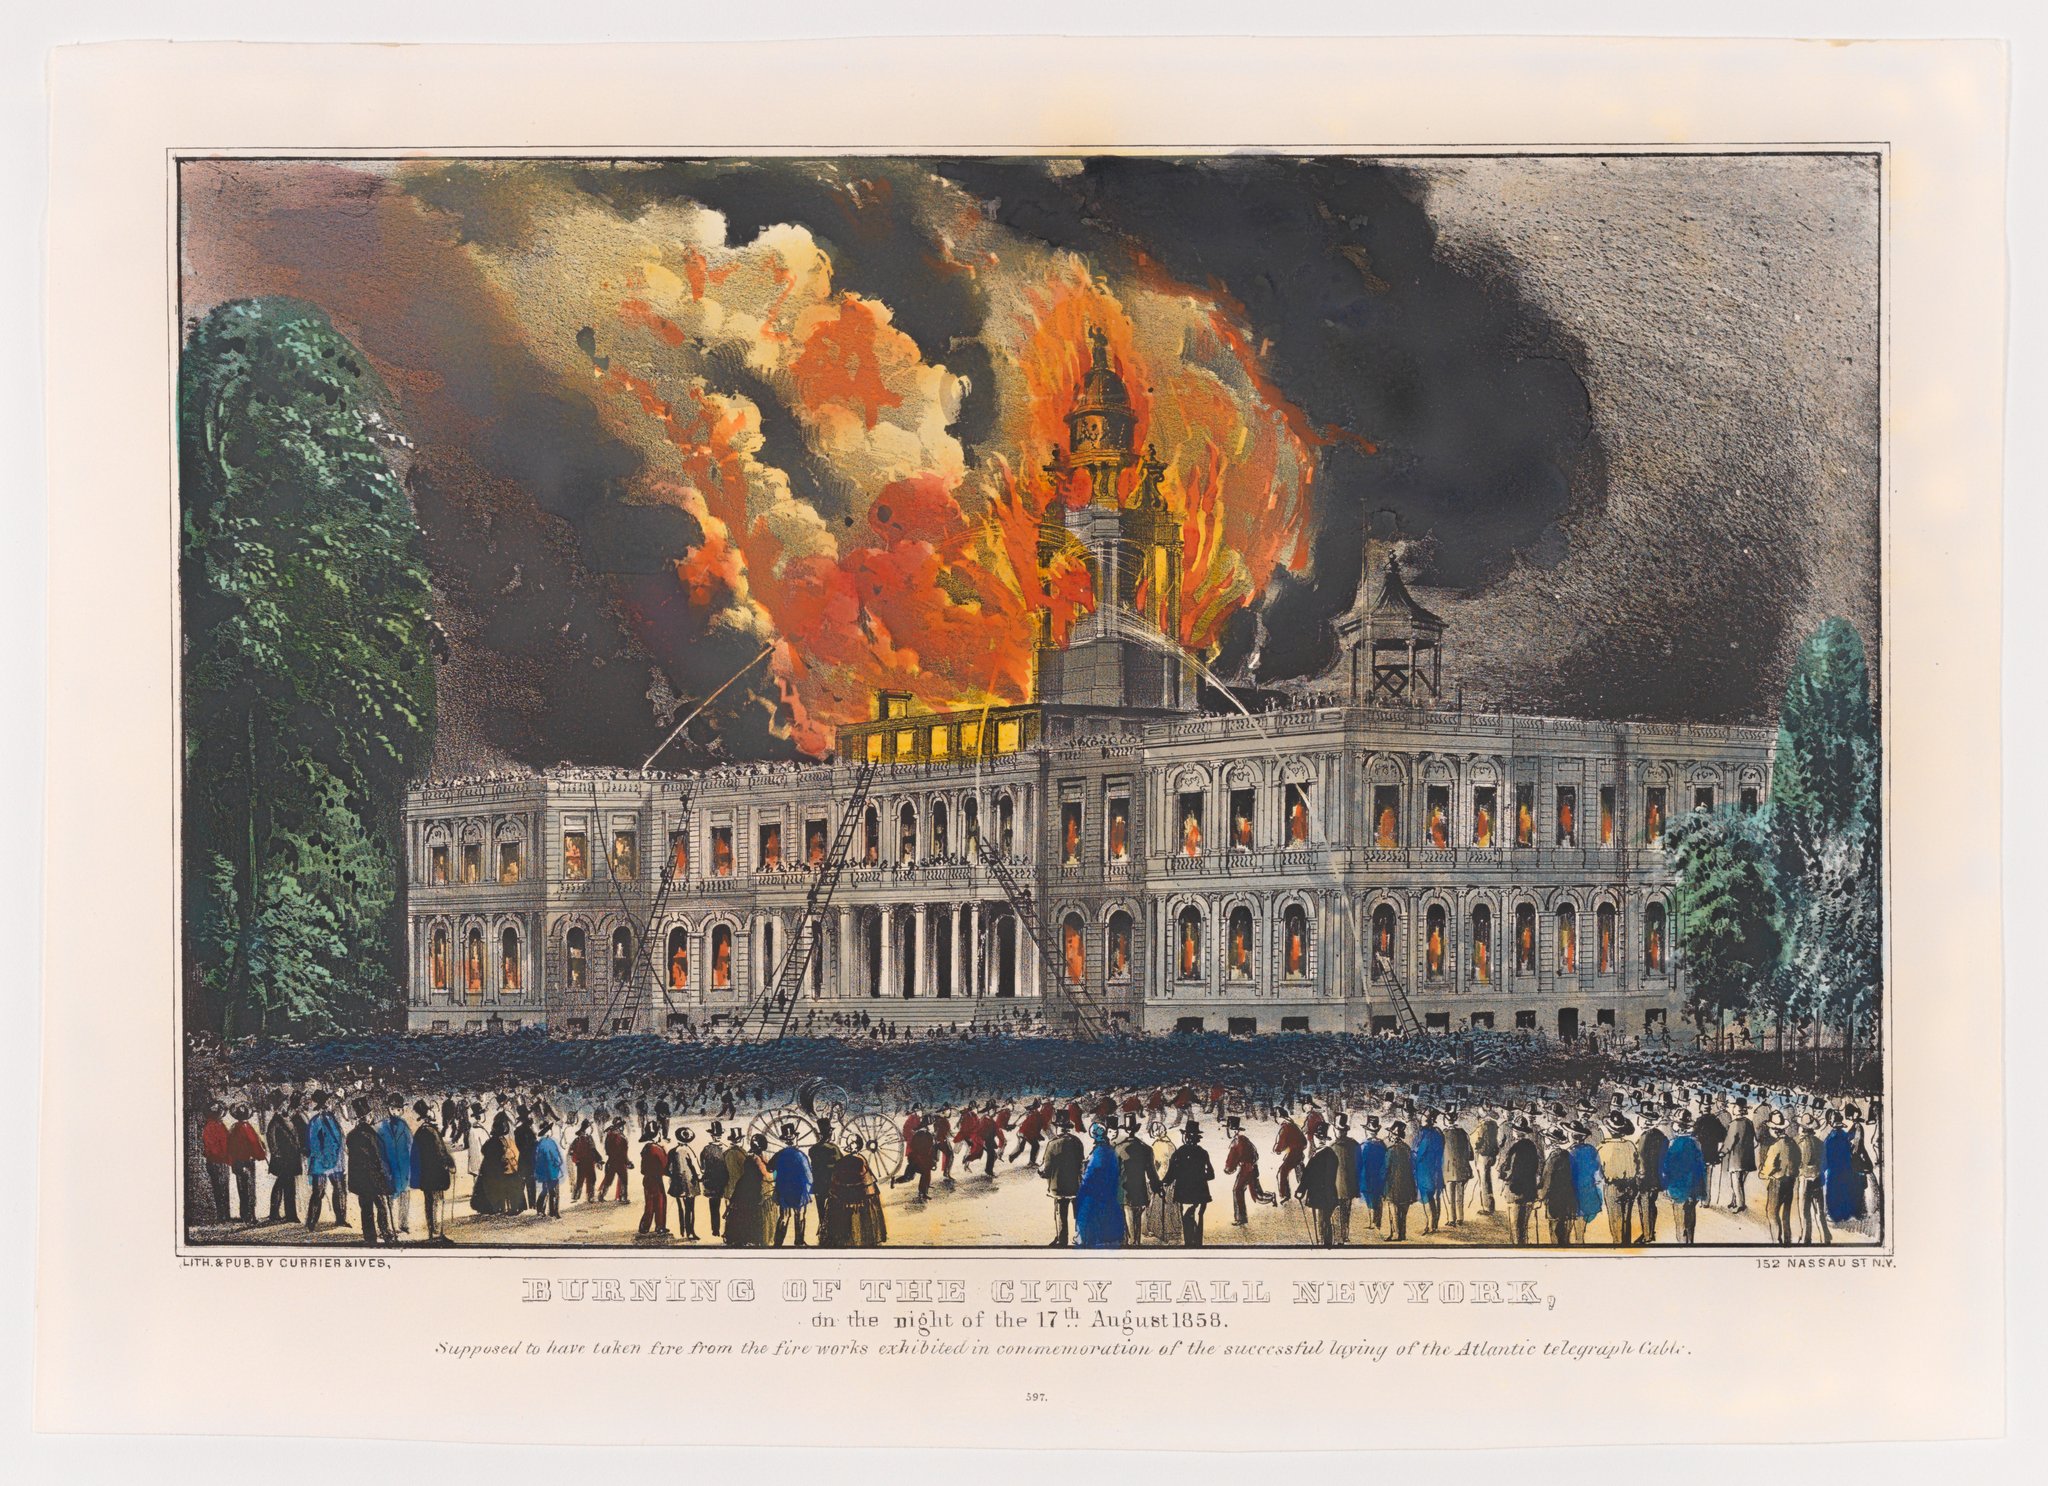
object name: print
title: Burning of the City Hall New York, on the night of the 17th August 1858 – Supposed to have taken fire from the fire works exhibited in commemoration of the successful laying of the Atlantic telegraph cable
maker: currier & ives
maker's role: publisher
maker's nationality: american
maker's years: 1857-1907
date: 1858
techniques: hand coloring, lithograph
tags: buildings,fire,new york city